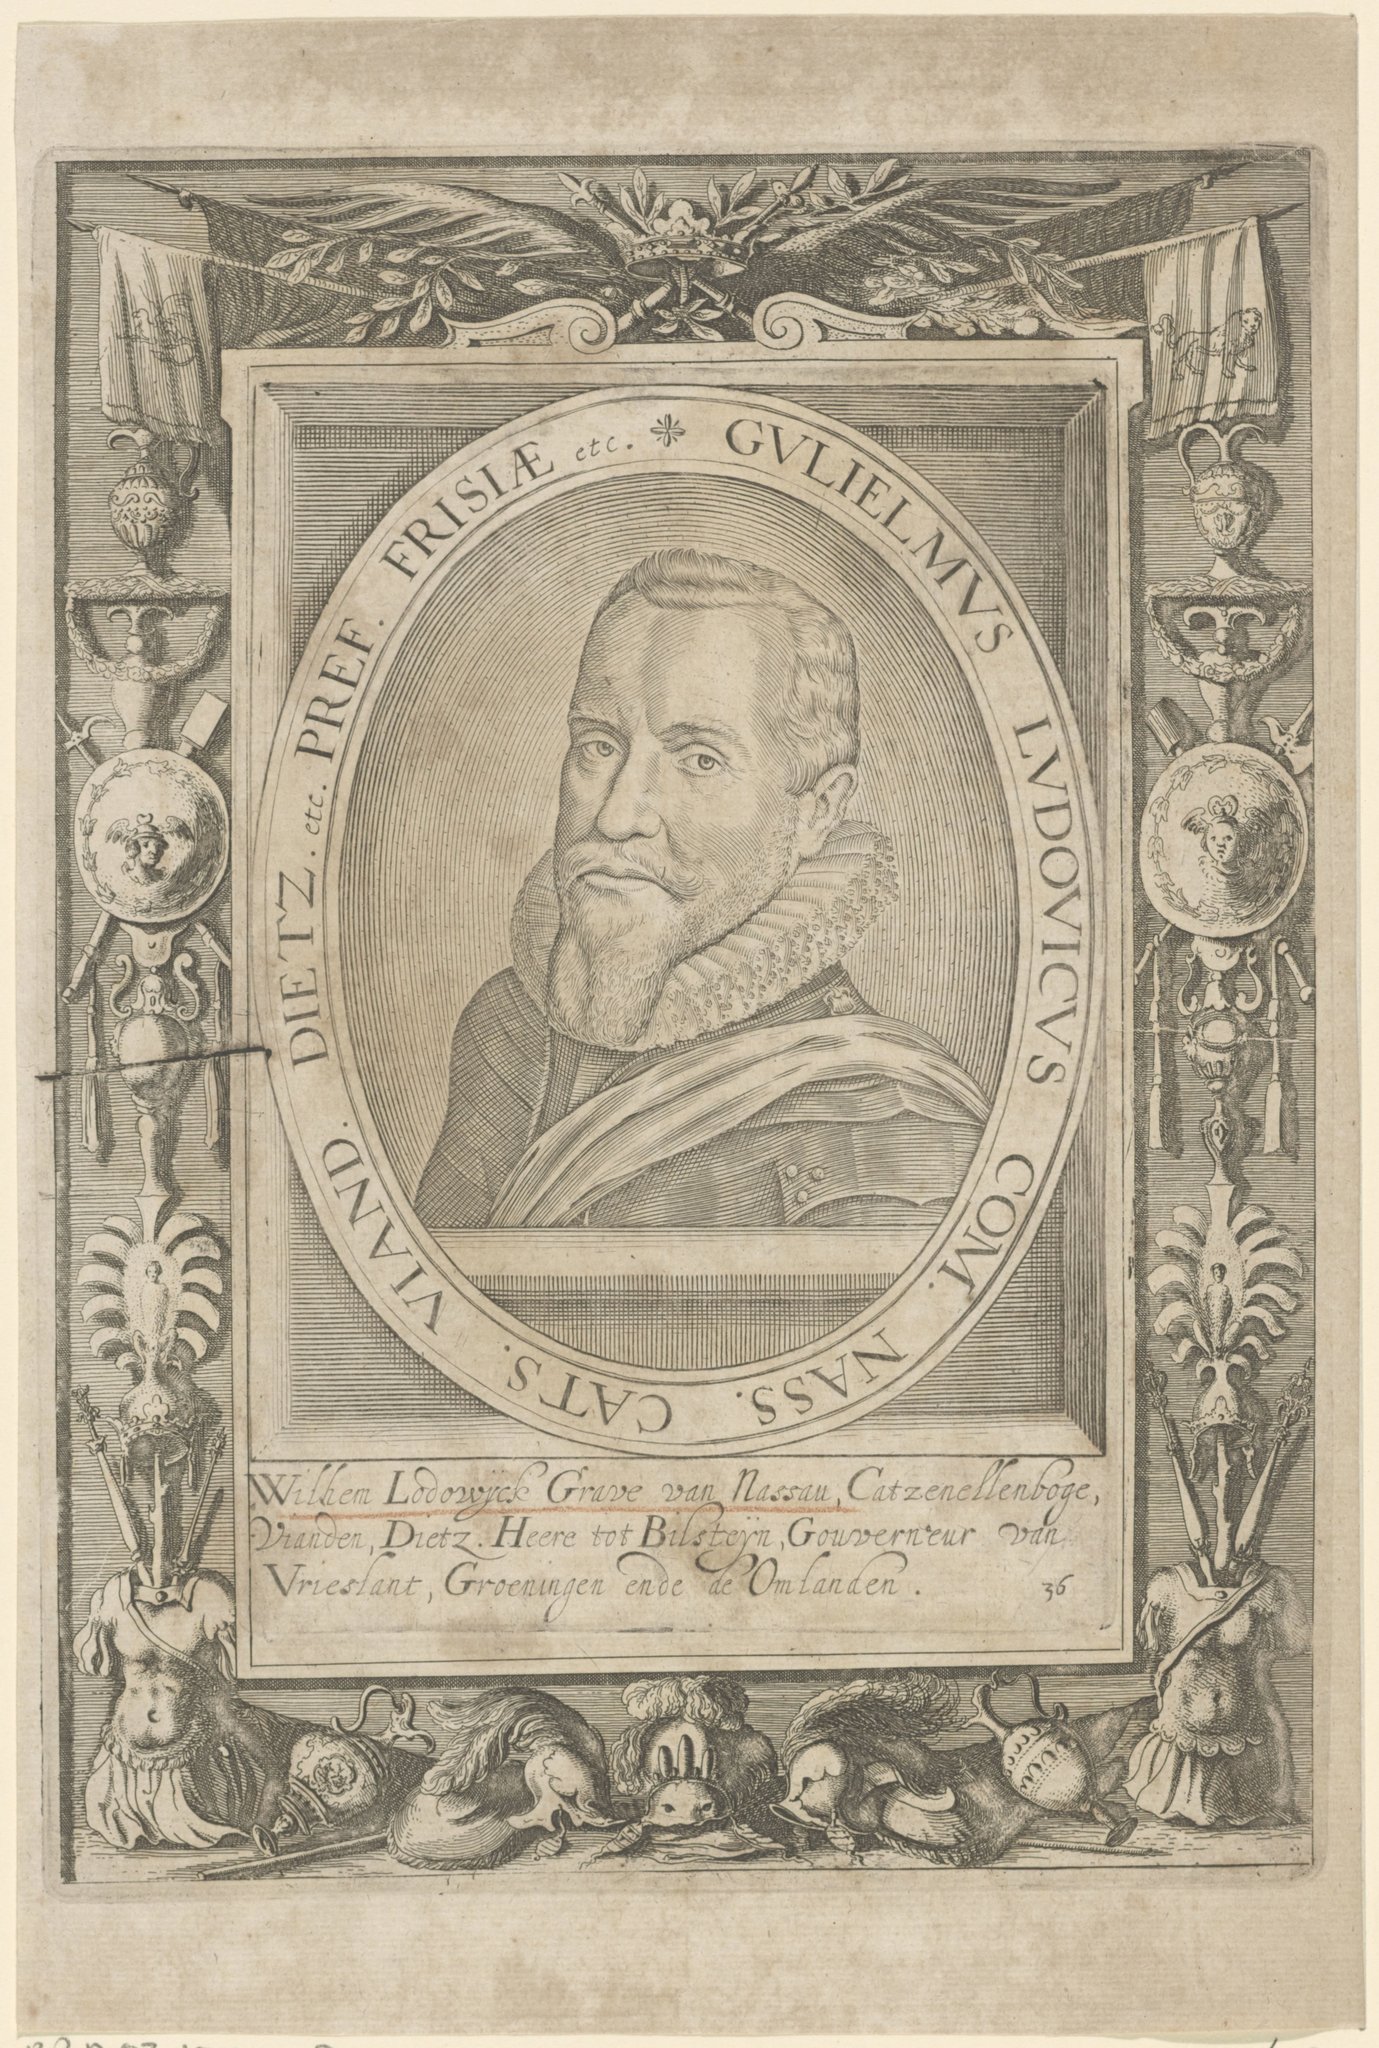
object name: print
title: Portret van Willem Lodewijk, graaf van Nassau-Dillenburg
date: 1640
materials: paper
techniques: engraving, etching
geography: amsterdam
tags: willem lodewijk graaf van nassau-dillenburg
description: De hier vermelde titel verwijst naar de hoogst verkregen titel van de geportretteerde, niet per se naar de titel die de geportretteerde op deze voorstelling draagt. Prent uit: Meteren, Emanuel van. Niderlandische Historien. Amsterdam: Johannes Janssonius, 1640.